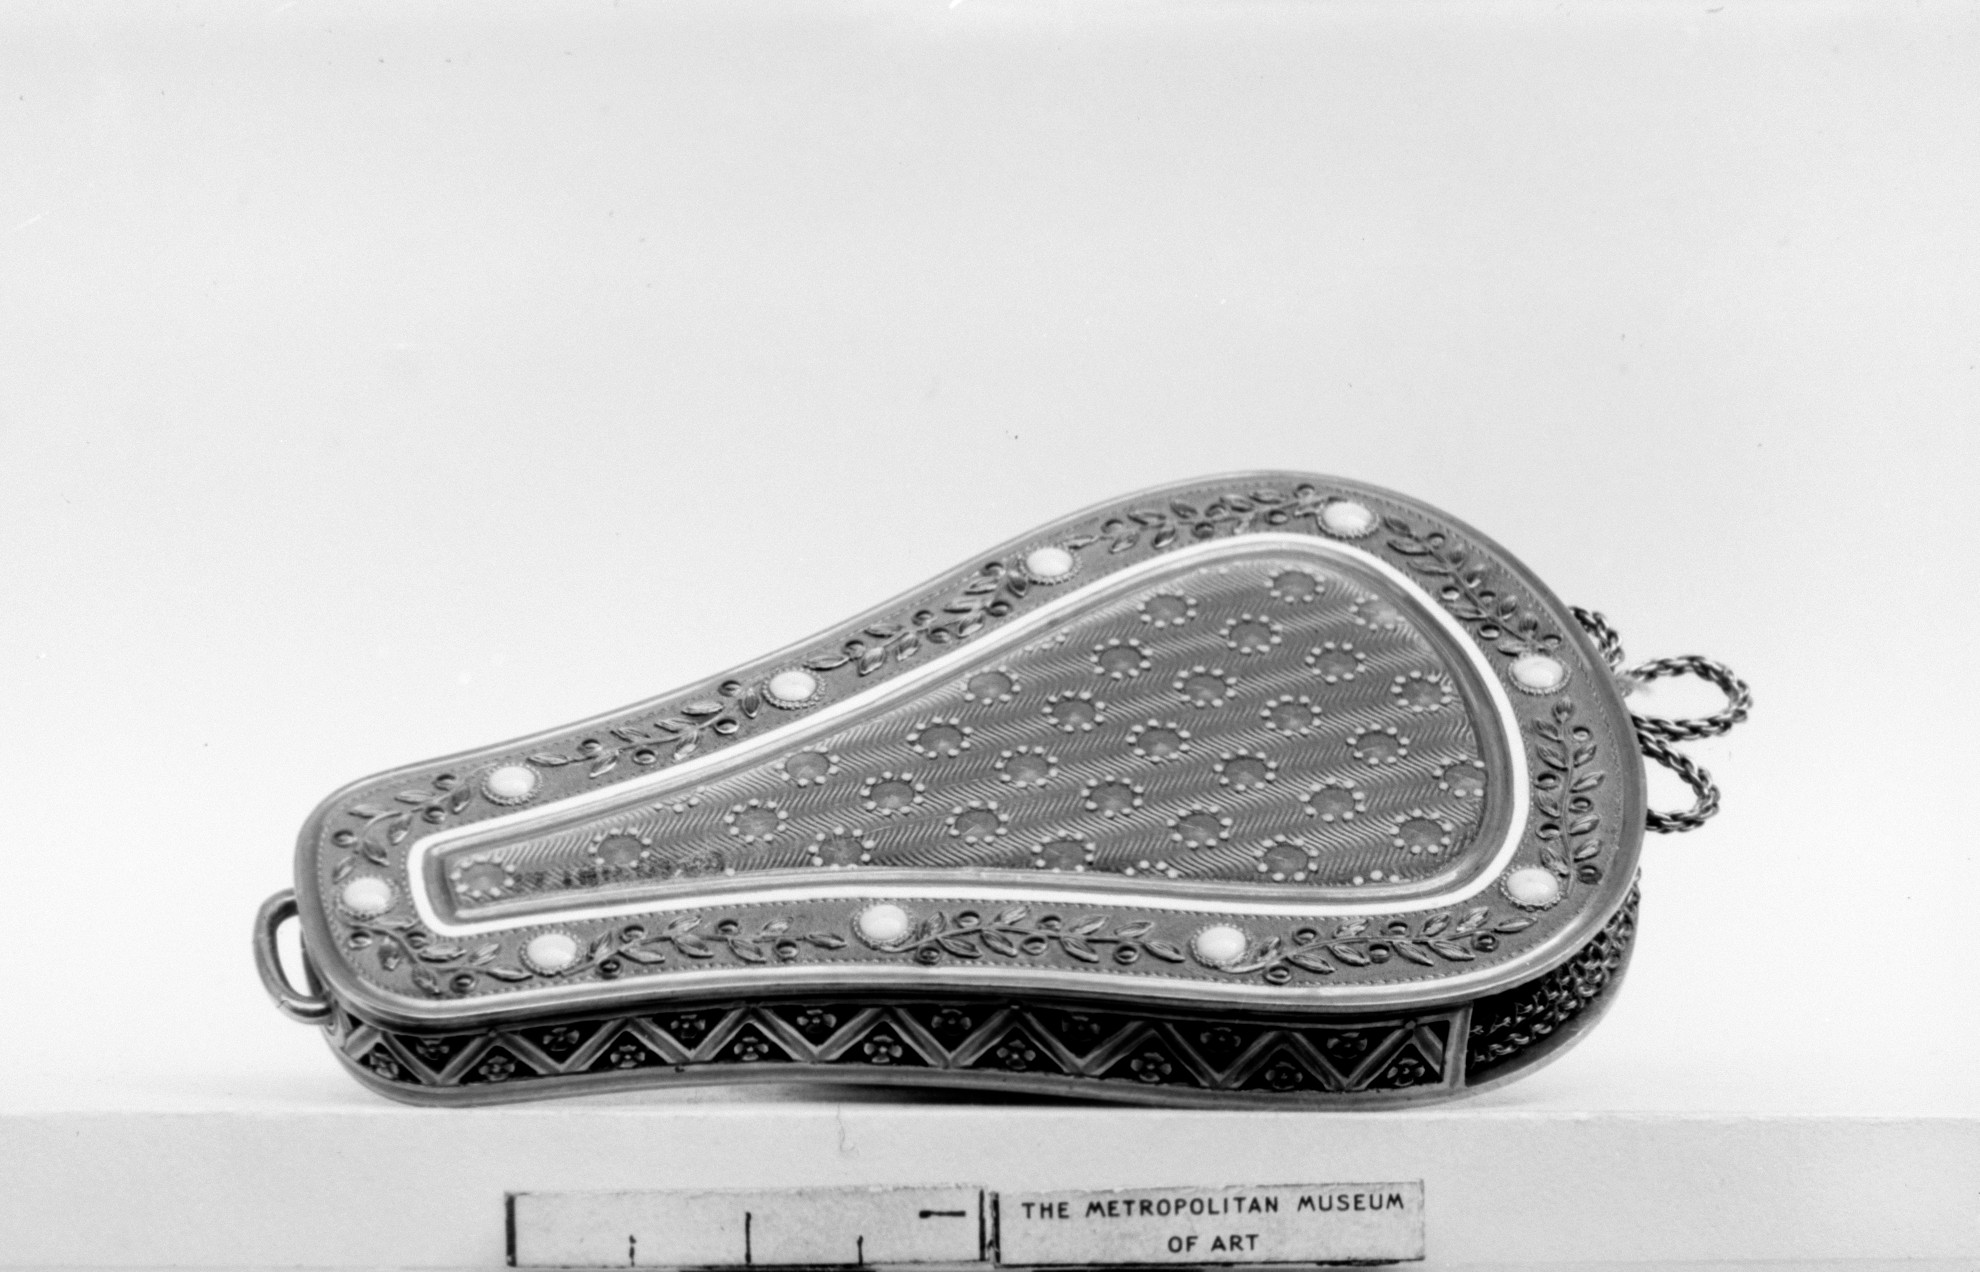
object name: needle book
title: Needle-book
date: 1801-1900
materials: enamel, gold